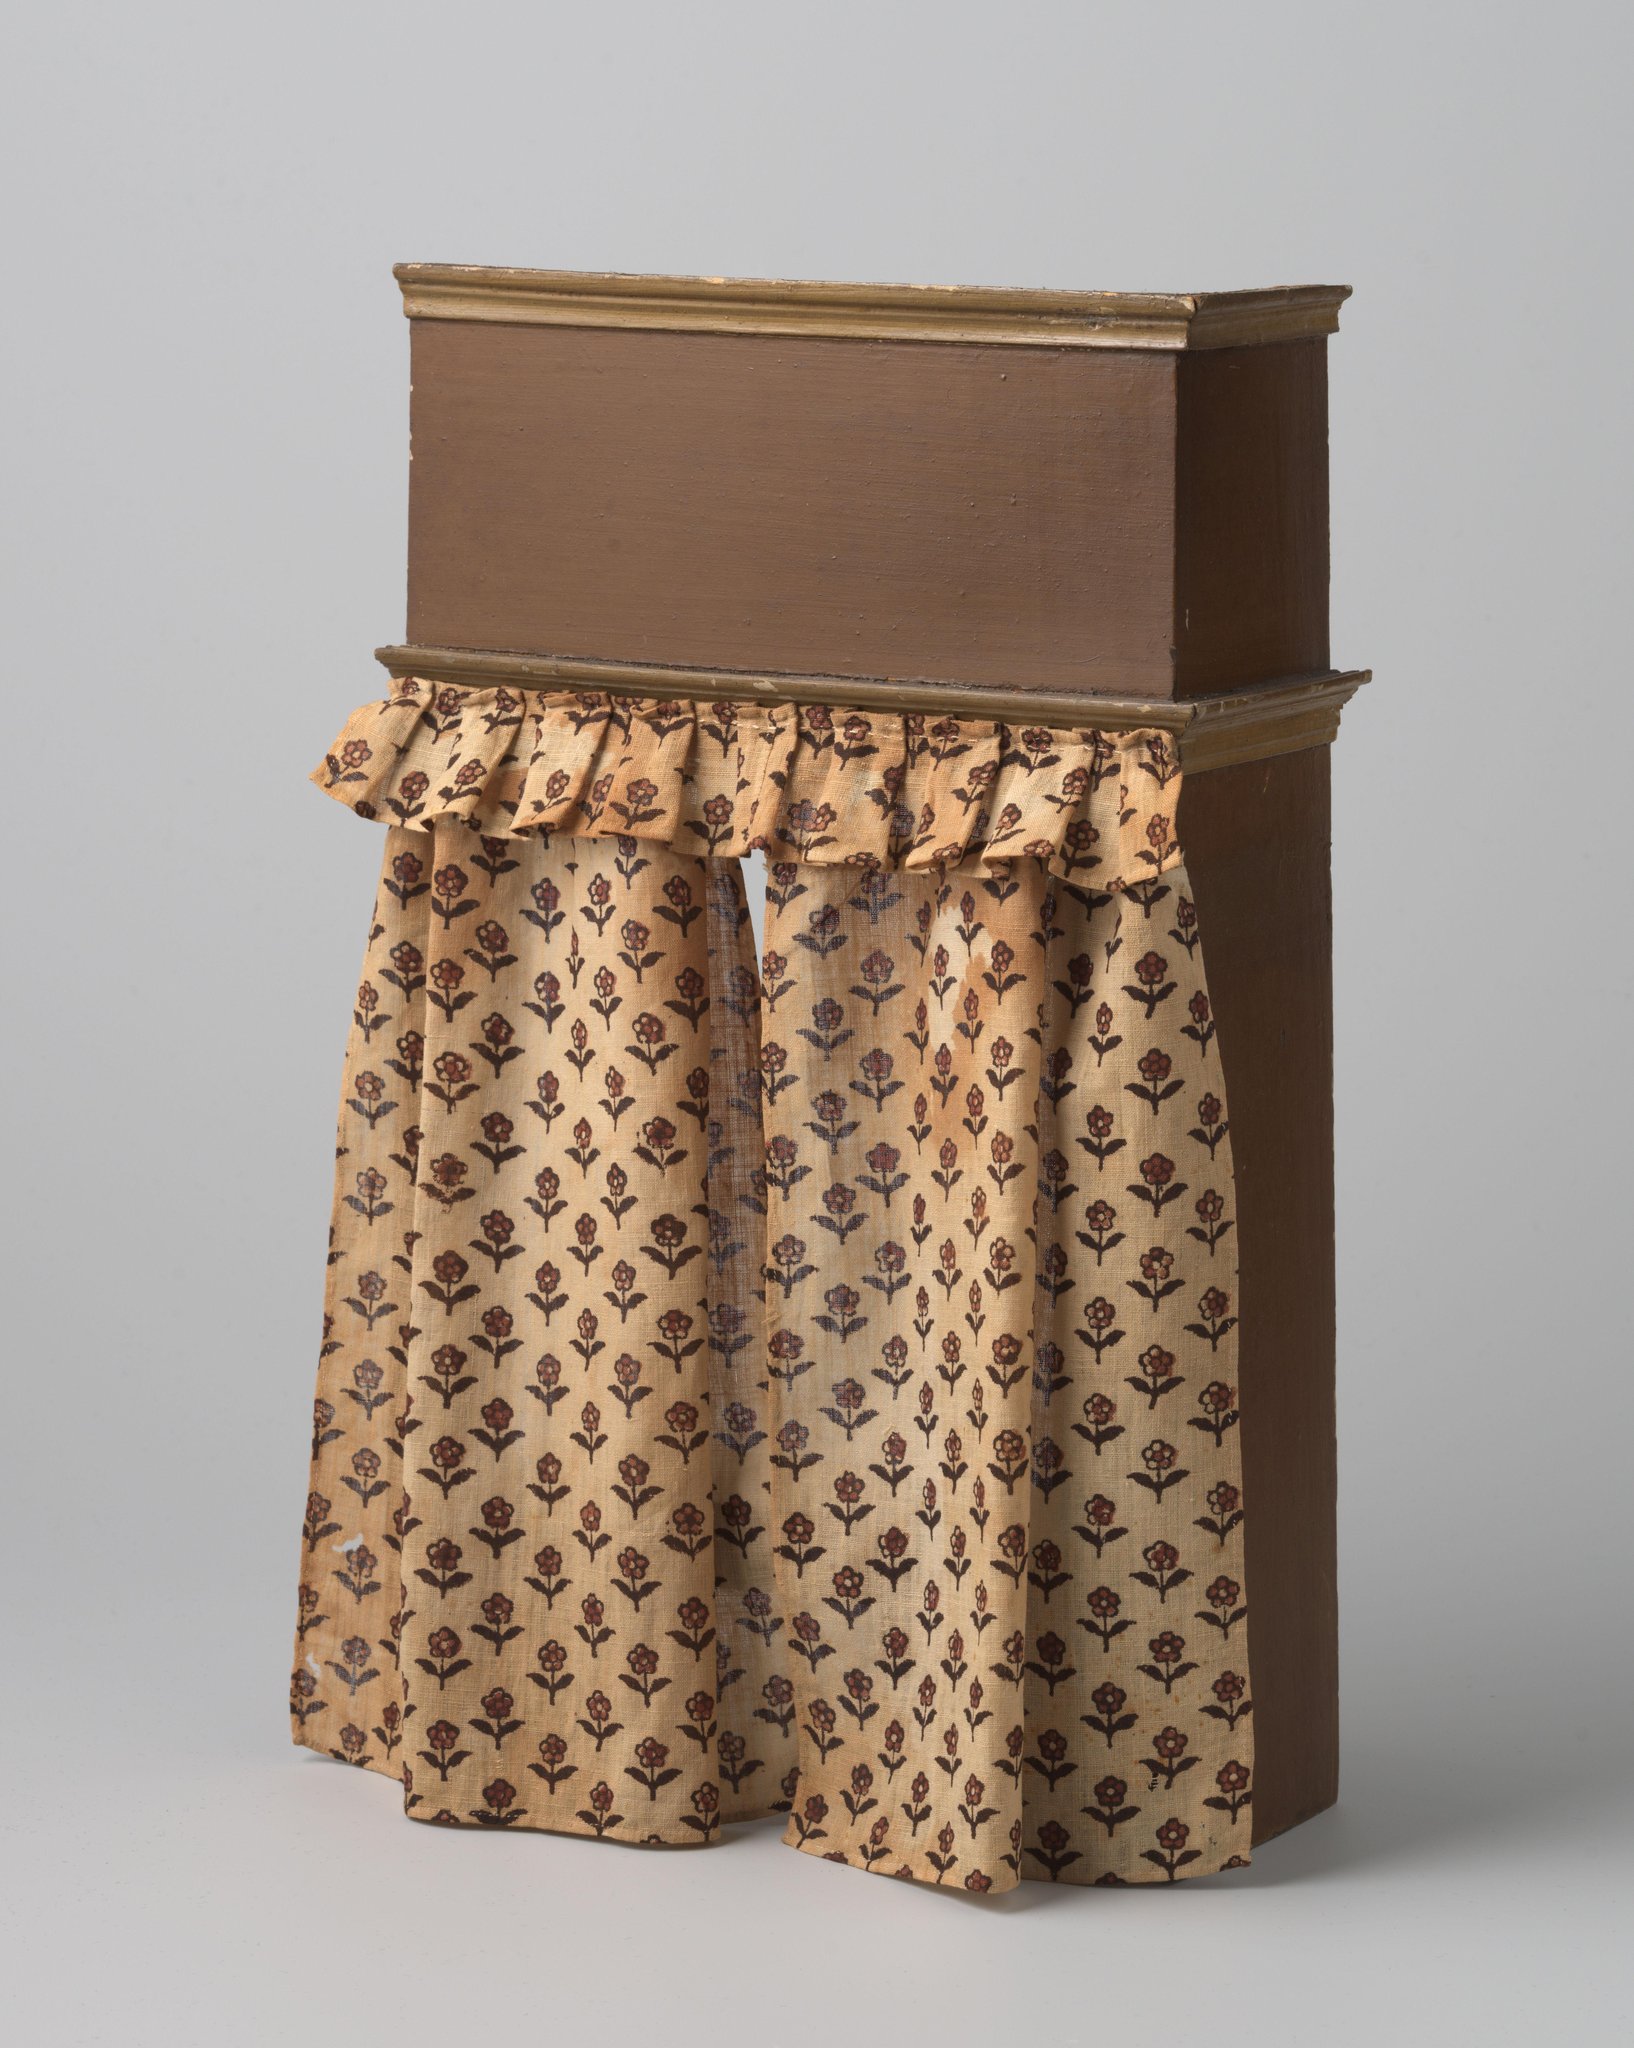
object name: miniature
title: Gordijn van bedstede, van bedrukte katoen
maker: Anonymous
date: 1690-1710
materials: copper, cotton, linen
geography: india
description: Gordijn voor een bedstede, vervaardigd van bedrukte katoen met verspringend motief van bloem op steeltje, zwart rood op witte achtergrond. De gordijn hangt met bandjes die door koperen ringen zijn gehaald, aan een koperen roede met oog aan één zijde. Door ringen beurtelings gedraaid aan roede te schuiven ontstaan de plooien in de gordijnen.